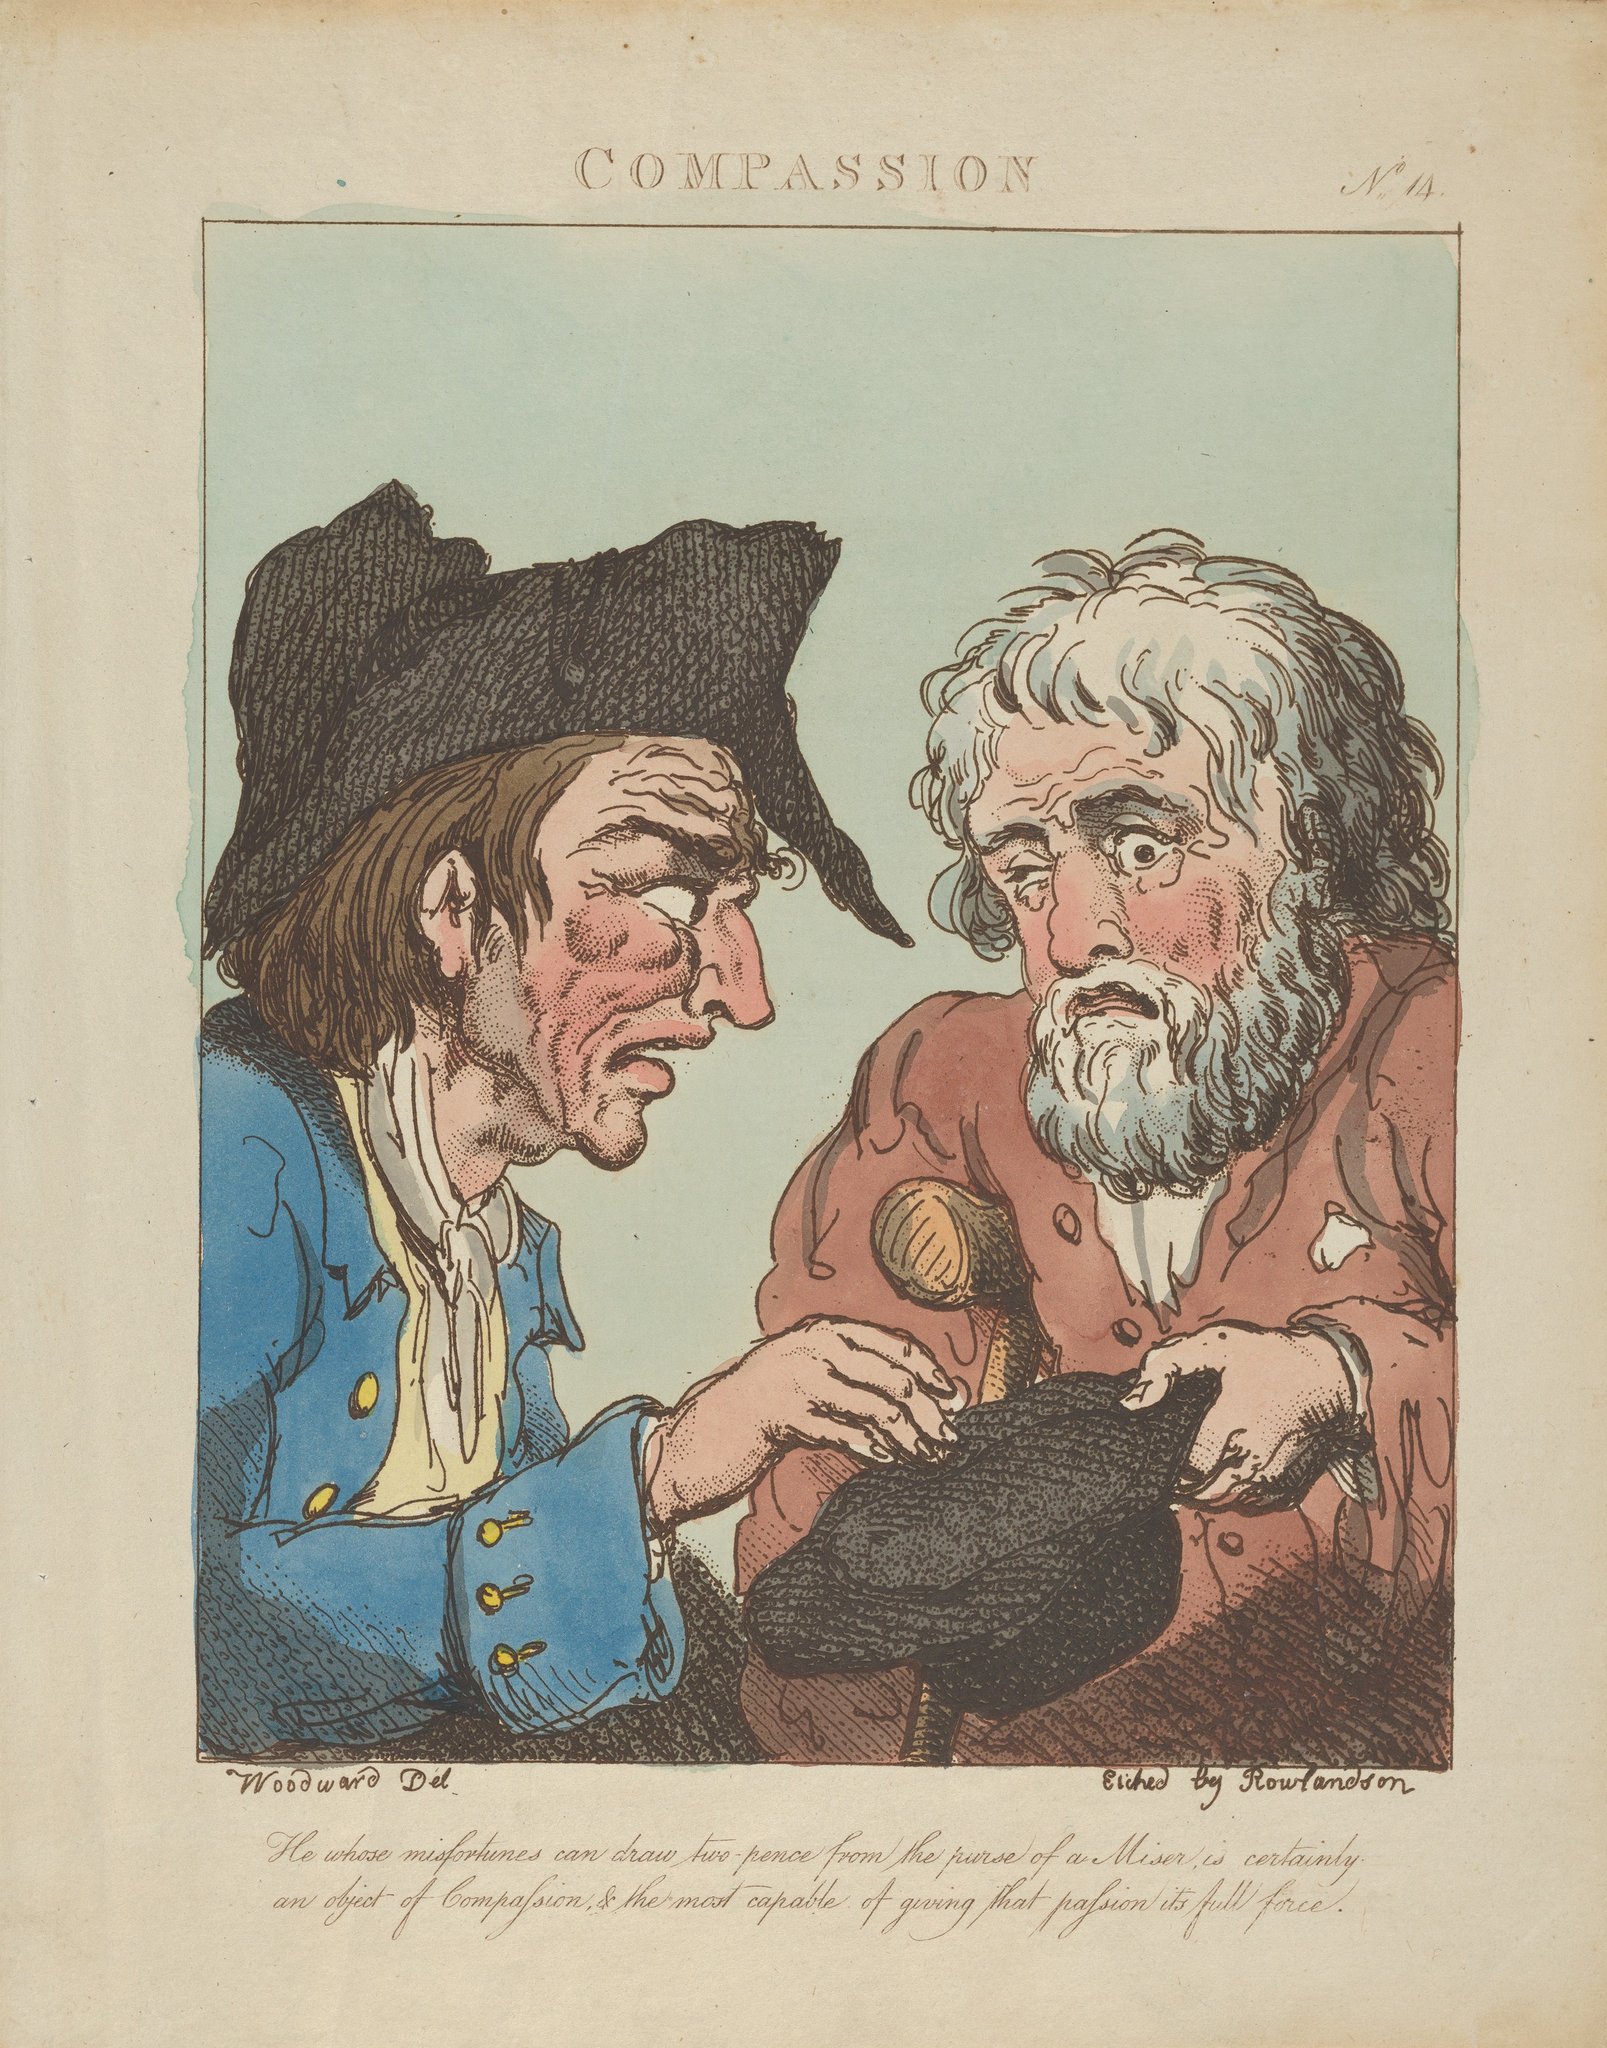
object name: print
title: Compassion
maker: thomas rowlandson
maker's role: artist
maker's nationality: british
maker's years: 1757-1827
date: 1800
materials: ink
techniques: etching, printing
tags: men